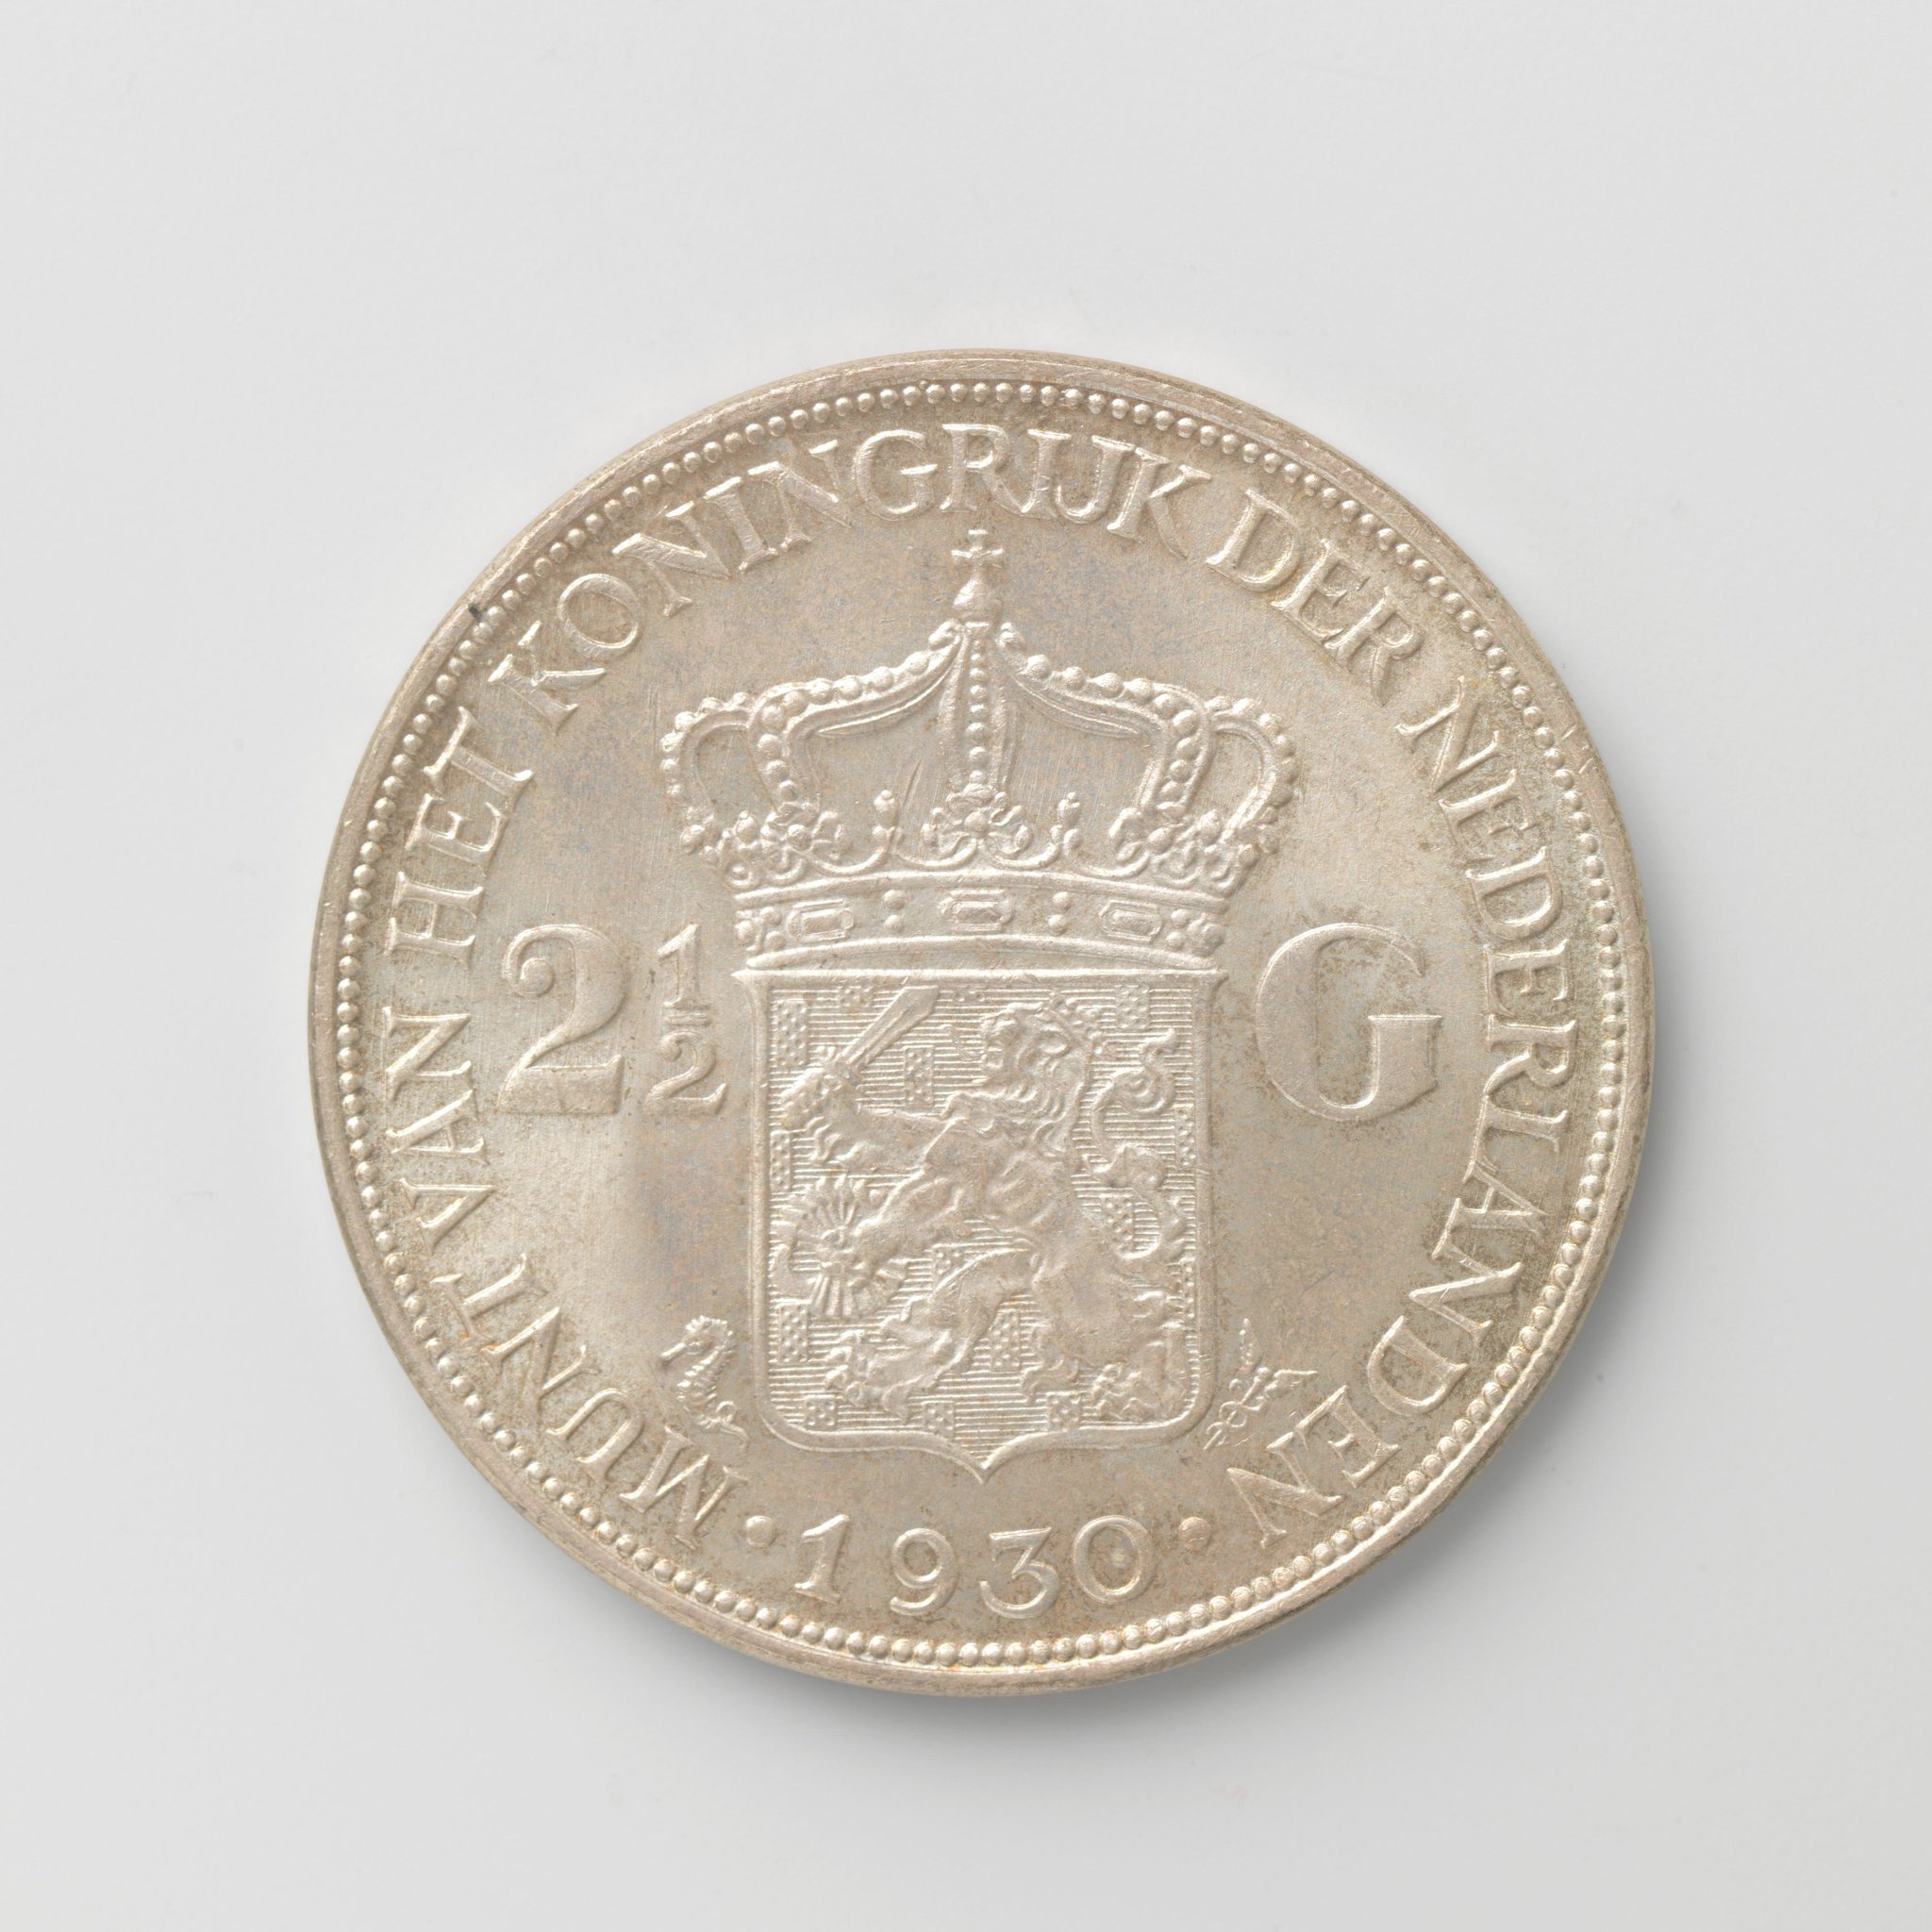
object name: coin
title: Nederland, 2½ gulden,1930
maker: wilhelmina of the netherlands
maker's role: print maker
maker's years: 1880-1962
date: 1930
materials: silver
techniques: striking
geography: utrecht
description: Zilveren munt. Voorzijde: hoofd naar links. Keerzijde: tussen waarde-aanduiding 2½ G gekroond rijkswapenschild. Jaartal onderaan in omschrift. Randschrift.